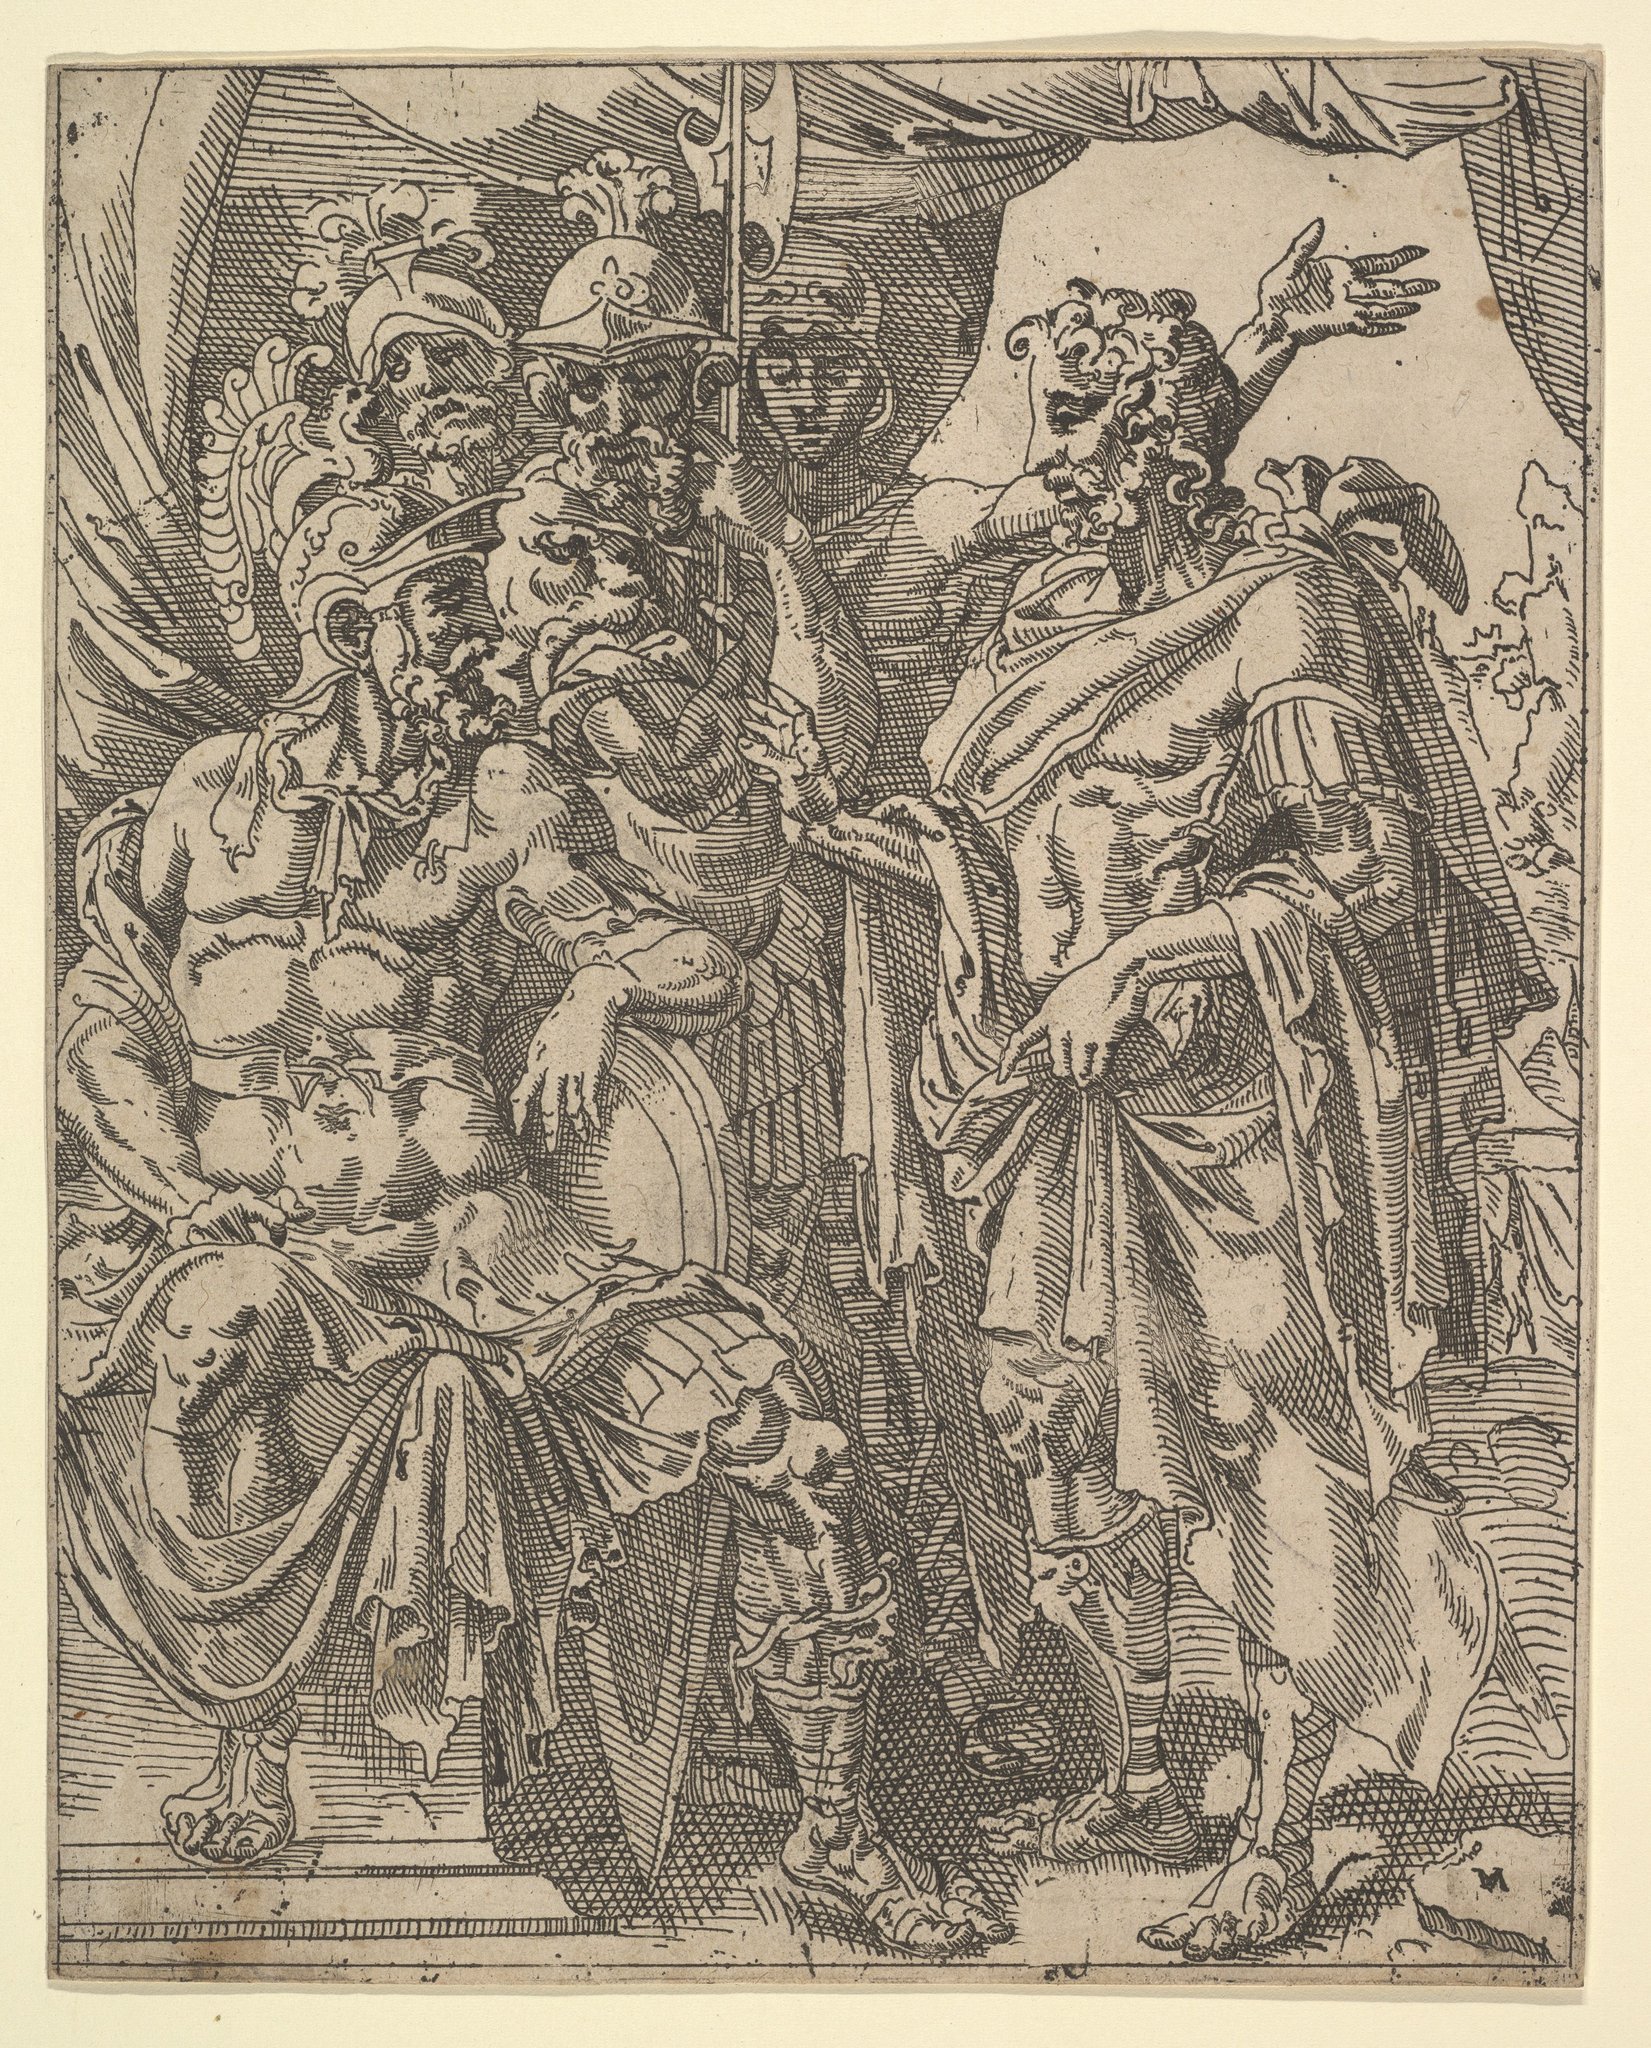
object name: print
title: Achior Pleading with Holofernes for the Israelites, from "The Story of Judith and Holofernes"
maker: maarten van heemskerck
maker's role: artist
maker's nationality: netherlandish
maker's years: 1498-1574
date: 1530-1580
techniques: etching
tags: weapons,men,holofernes